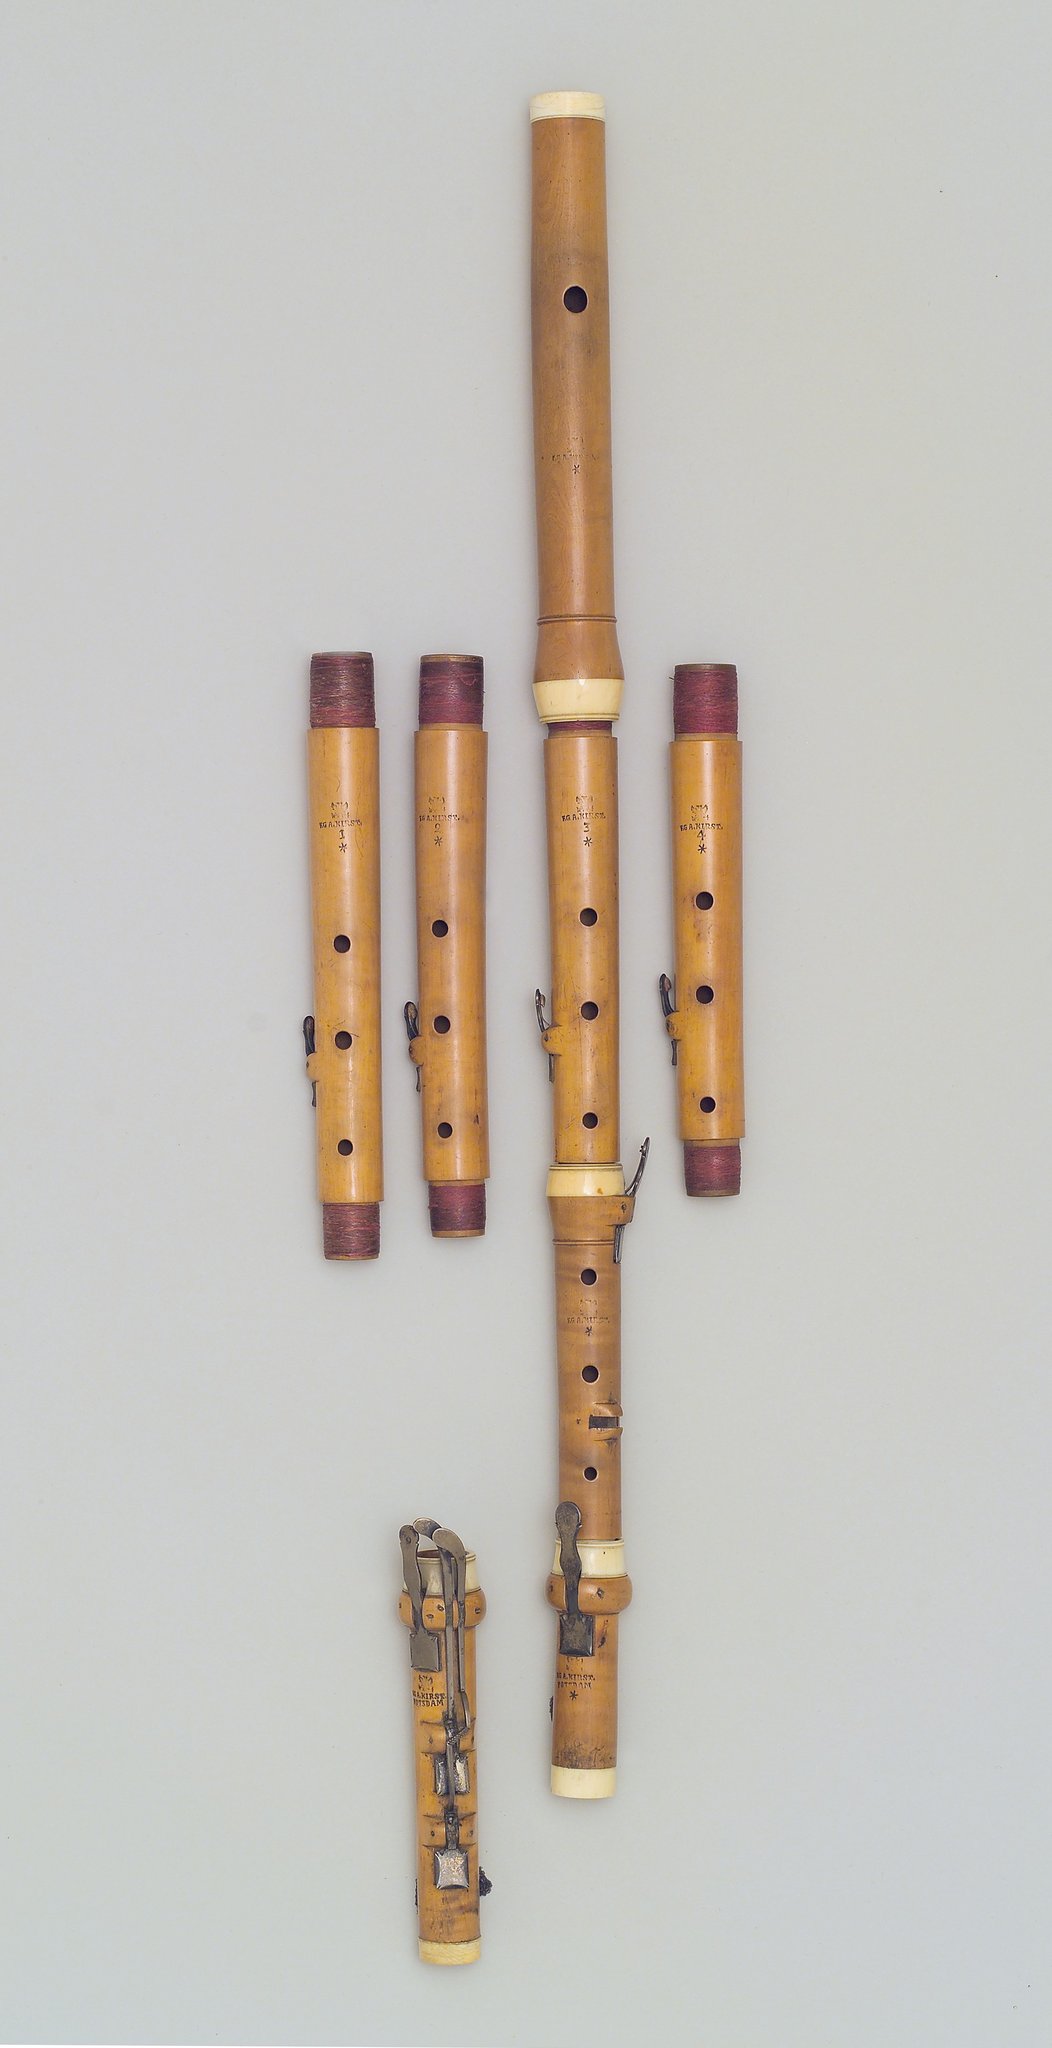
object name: transverse flute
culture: german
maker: friedrich gabriel august kirst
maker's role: musical instrument maker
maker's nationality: german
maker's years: 1750-1806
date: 1795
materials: wood, ivory, silver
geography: germany